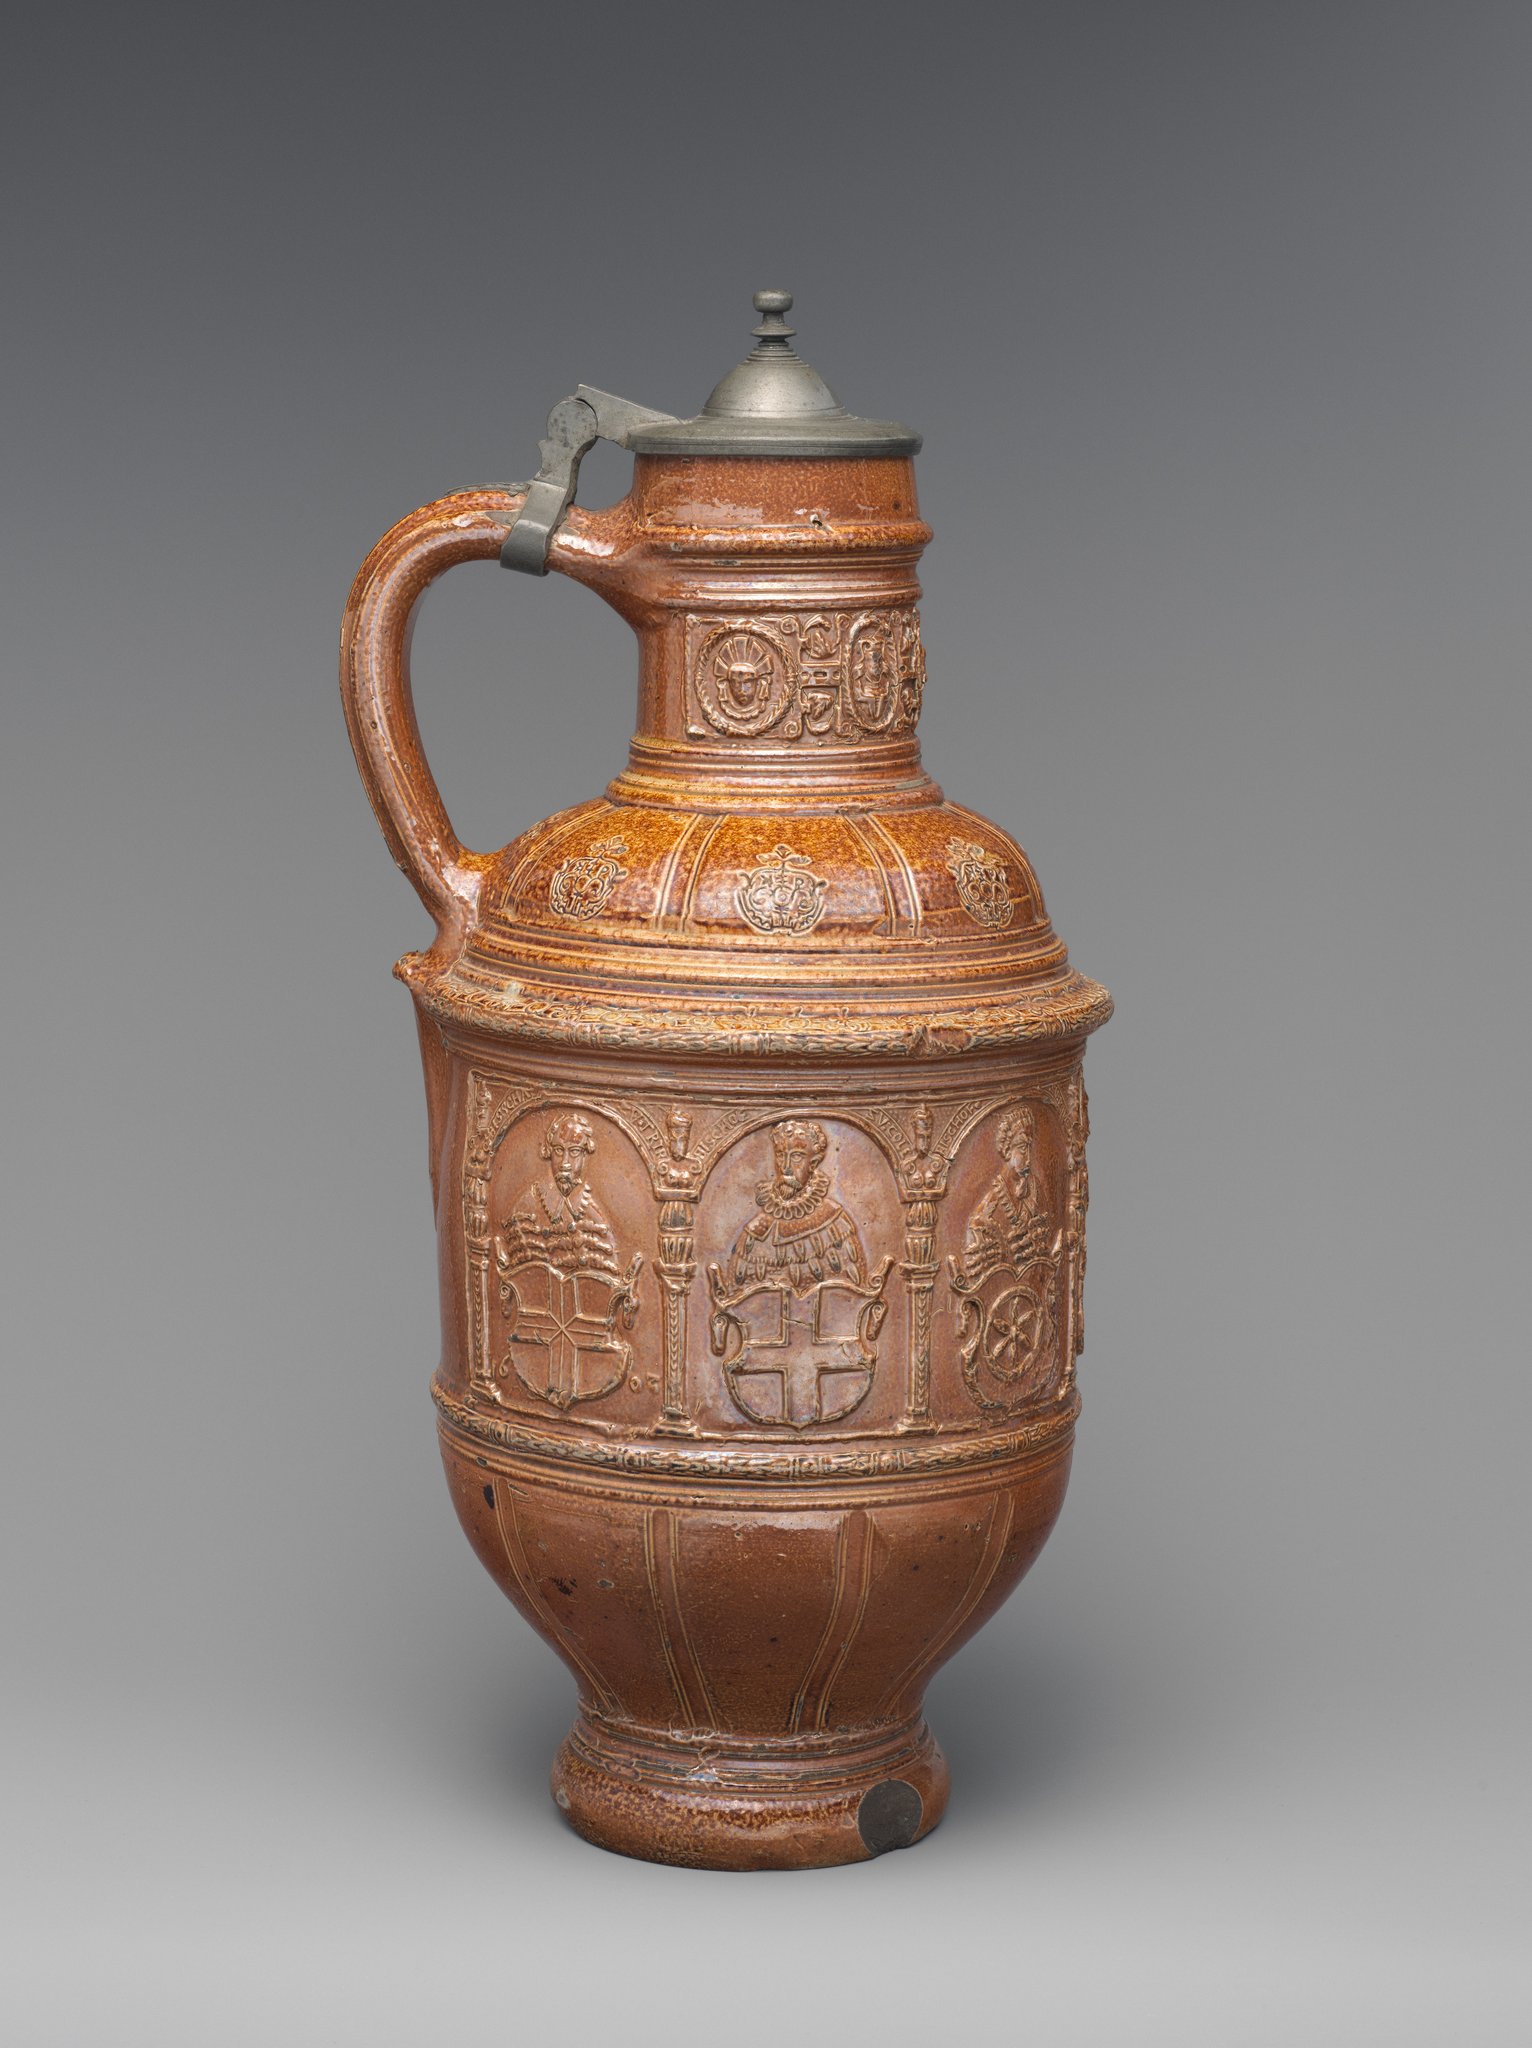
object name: jug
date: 1602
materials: pewter, stoneware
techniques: salt glaze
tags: men,portraits